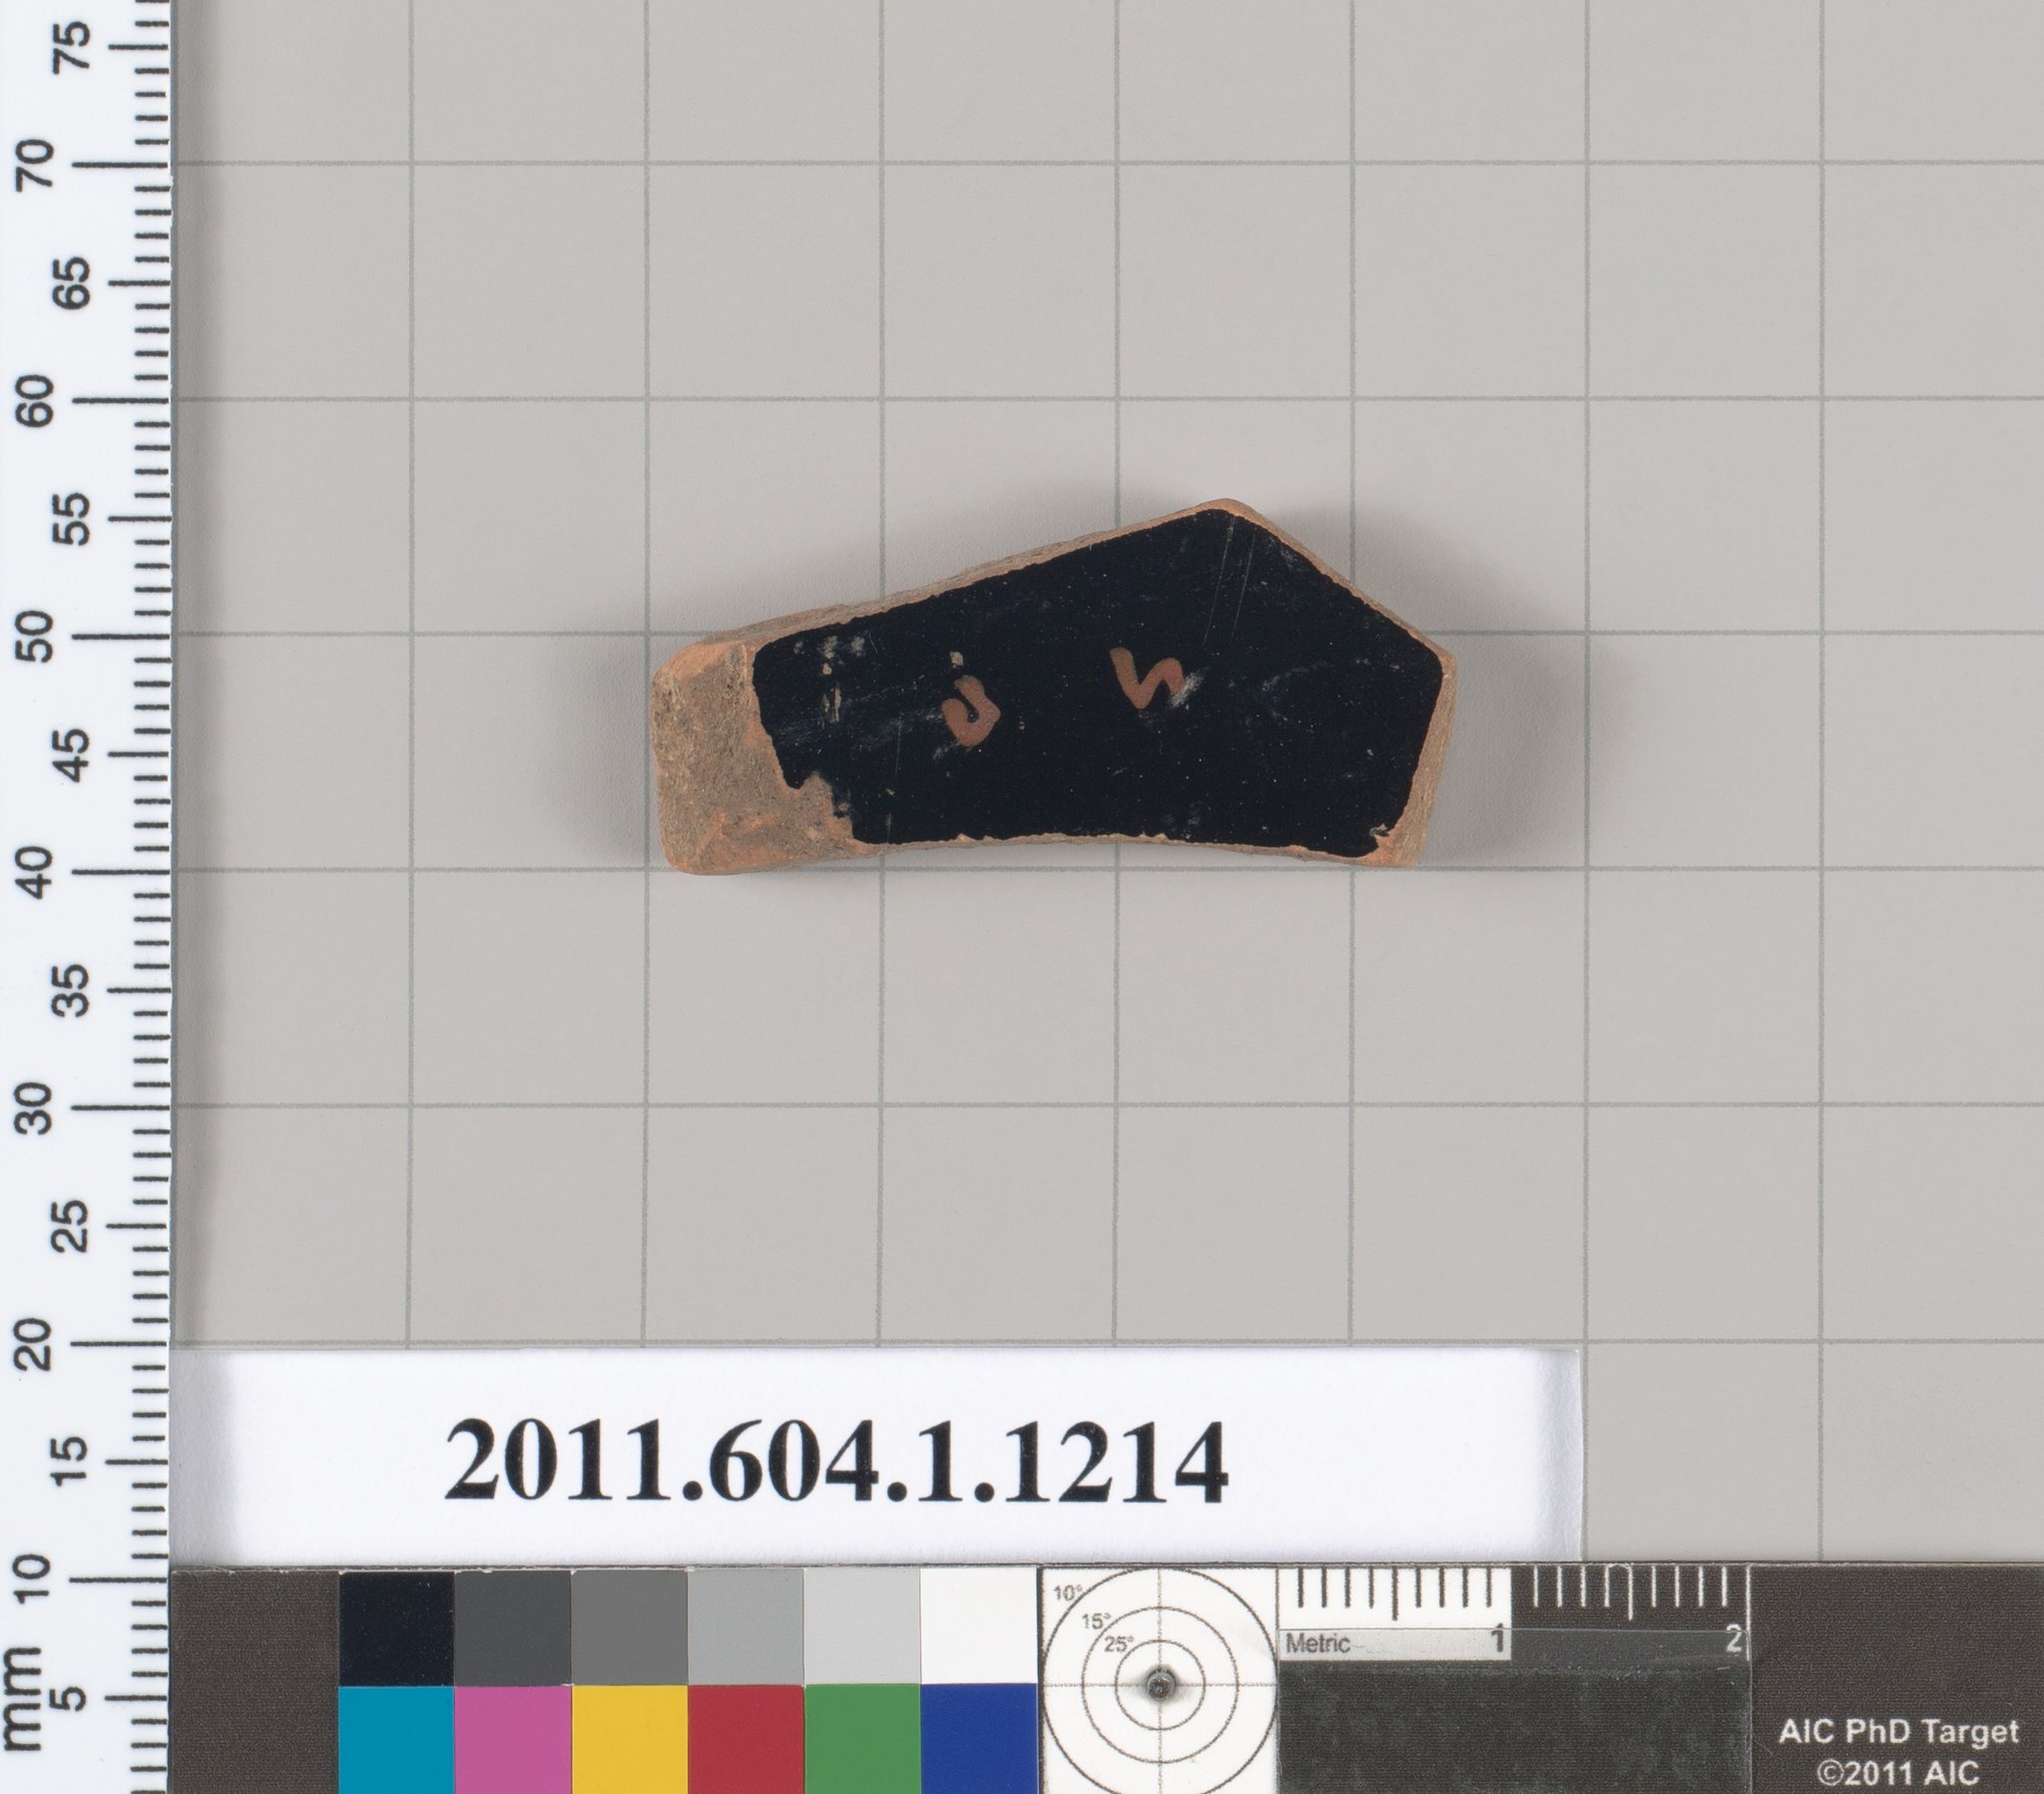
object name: kylix fragment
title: Terracotta fragment of a kylix (drinking cup)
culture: greek, attic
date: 490-480 BCE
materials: terracotta